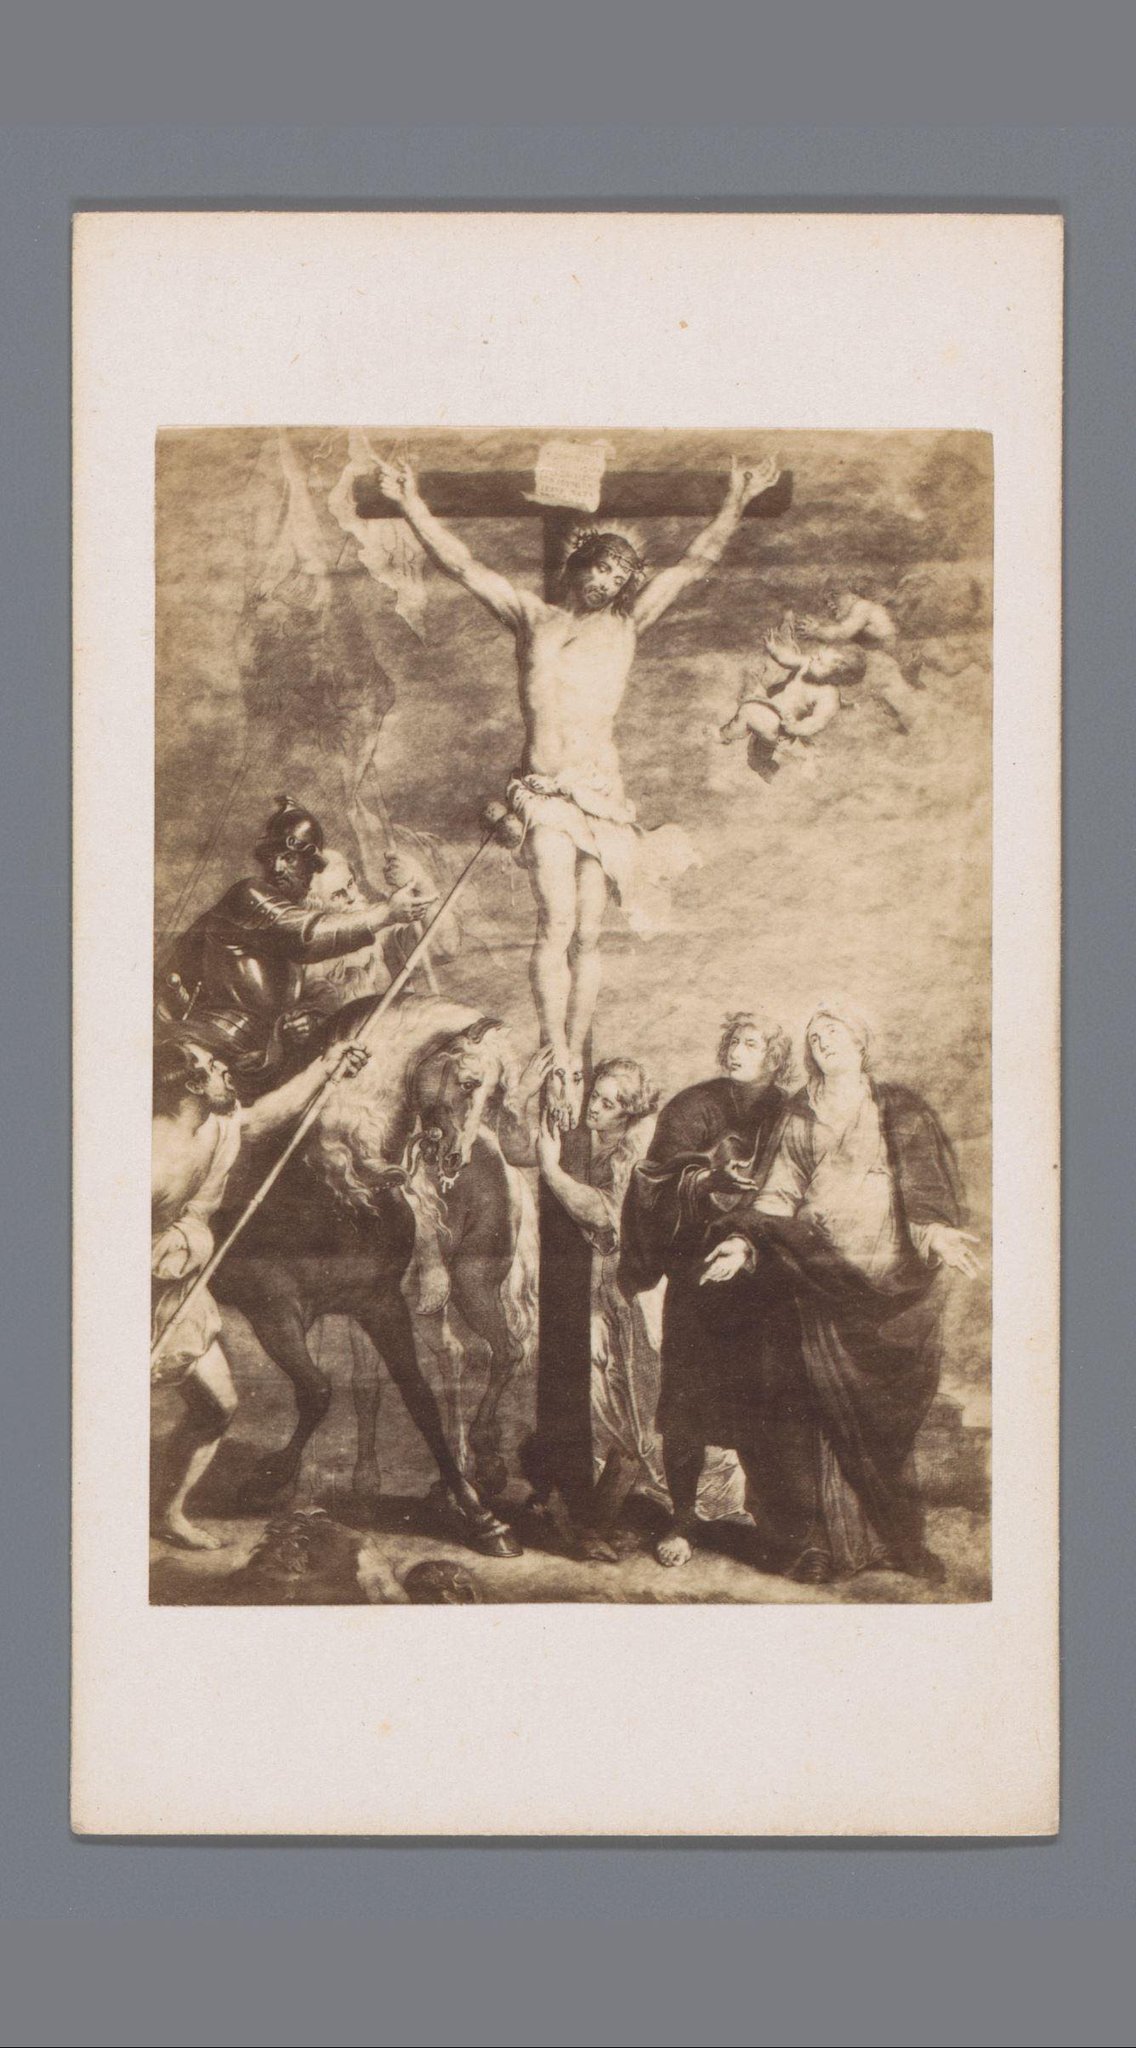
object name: carte de visite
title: Fotoreproductie van een prent van Christus aan het kruis naar het schilderij van Van Dyck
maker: Anonymous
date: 1855-1885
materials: cardboard, paper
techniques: albumen print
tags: crucified christ with mary, john, and mary magdalene, bystanders at the foot of the cross, among whom mary, mary magdalene and john the evangelist; mary may be shown swooning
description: Het schilderij van Anthony van Dyck bevindt zich in de Sint-Michielskerk in Gent.